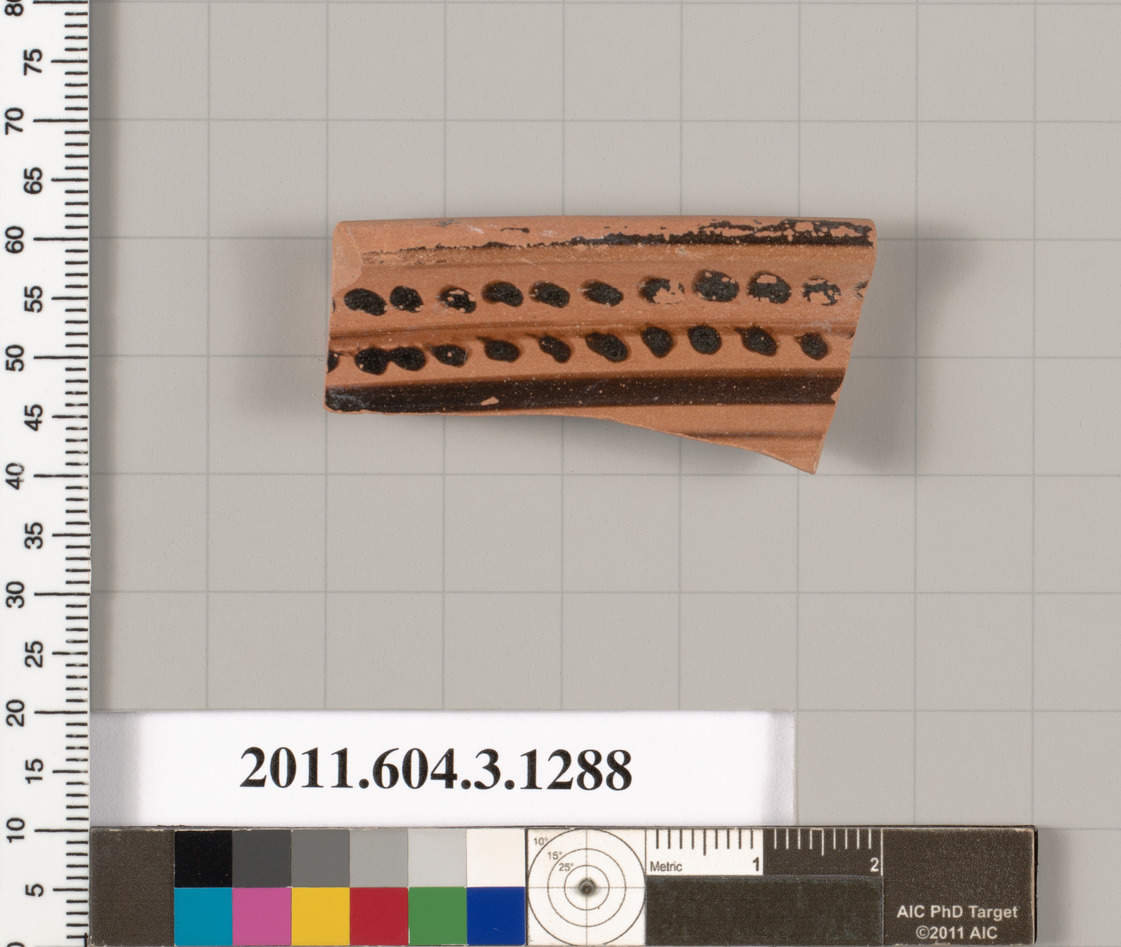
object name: skyphos fragment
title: Terracotta rim fragment of a skyphos (deep drinking cup)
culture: greek, attic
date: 500 BCE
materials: terracotta